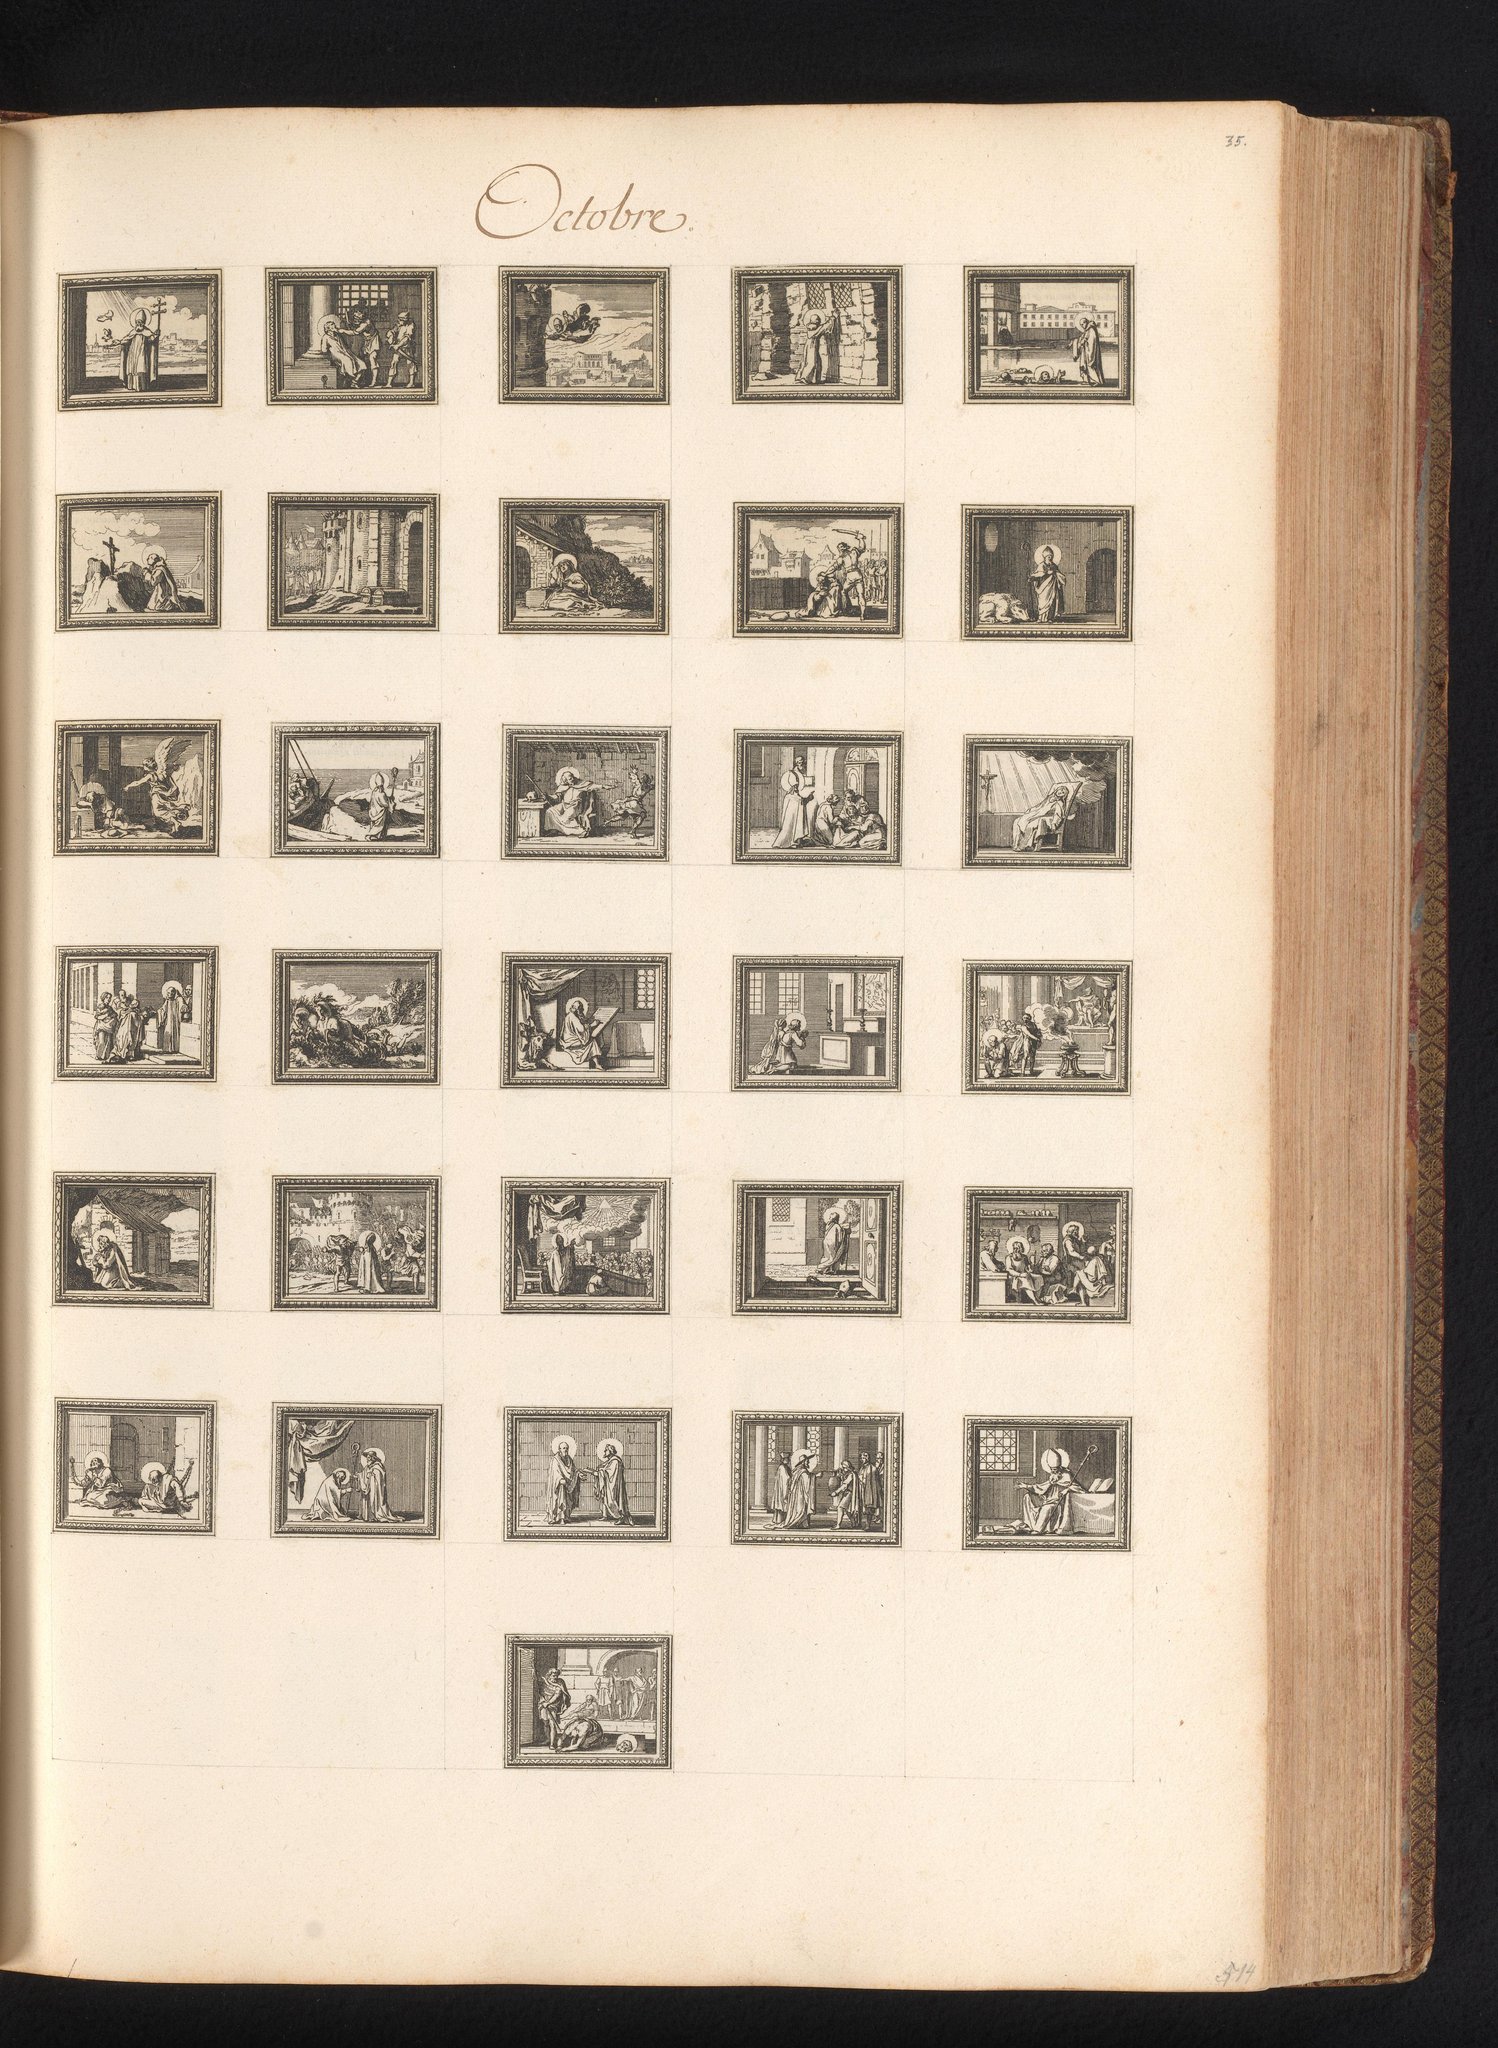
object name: album leaf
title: Saints d'Audran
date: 1687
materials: ink, paper, pencil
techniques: etching, pen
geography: paris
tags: saints, october ~ other concepts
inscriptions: inscription: ‘Octobre.’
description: Prenten gebruikt voor: Giraud, L'Abbé. L'invocation et l'imitation des saints pour tous les jours de l'année. Parijs: Gérard Audran, 1687, 4 vols. Deze prenten staan ook wel bekend als de 'Saints d'Audran', zie IFF 17e siècle dl. 9, p. 118-119, nr. 1796-2174.